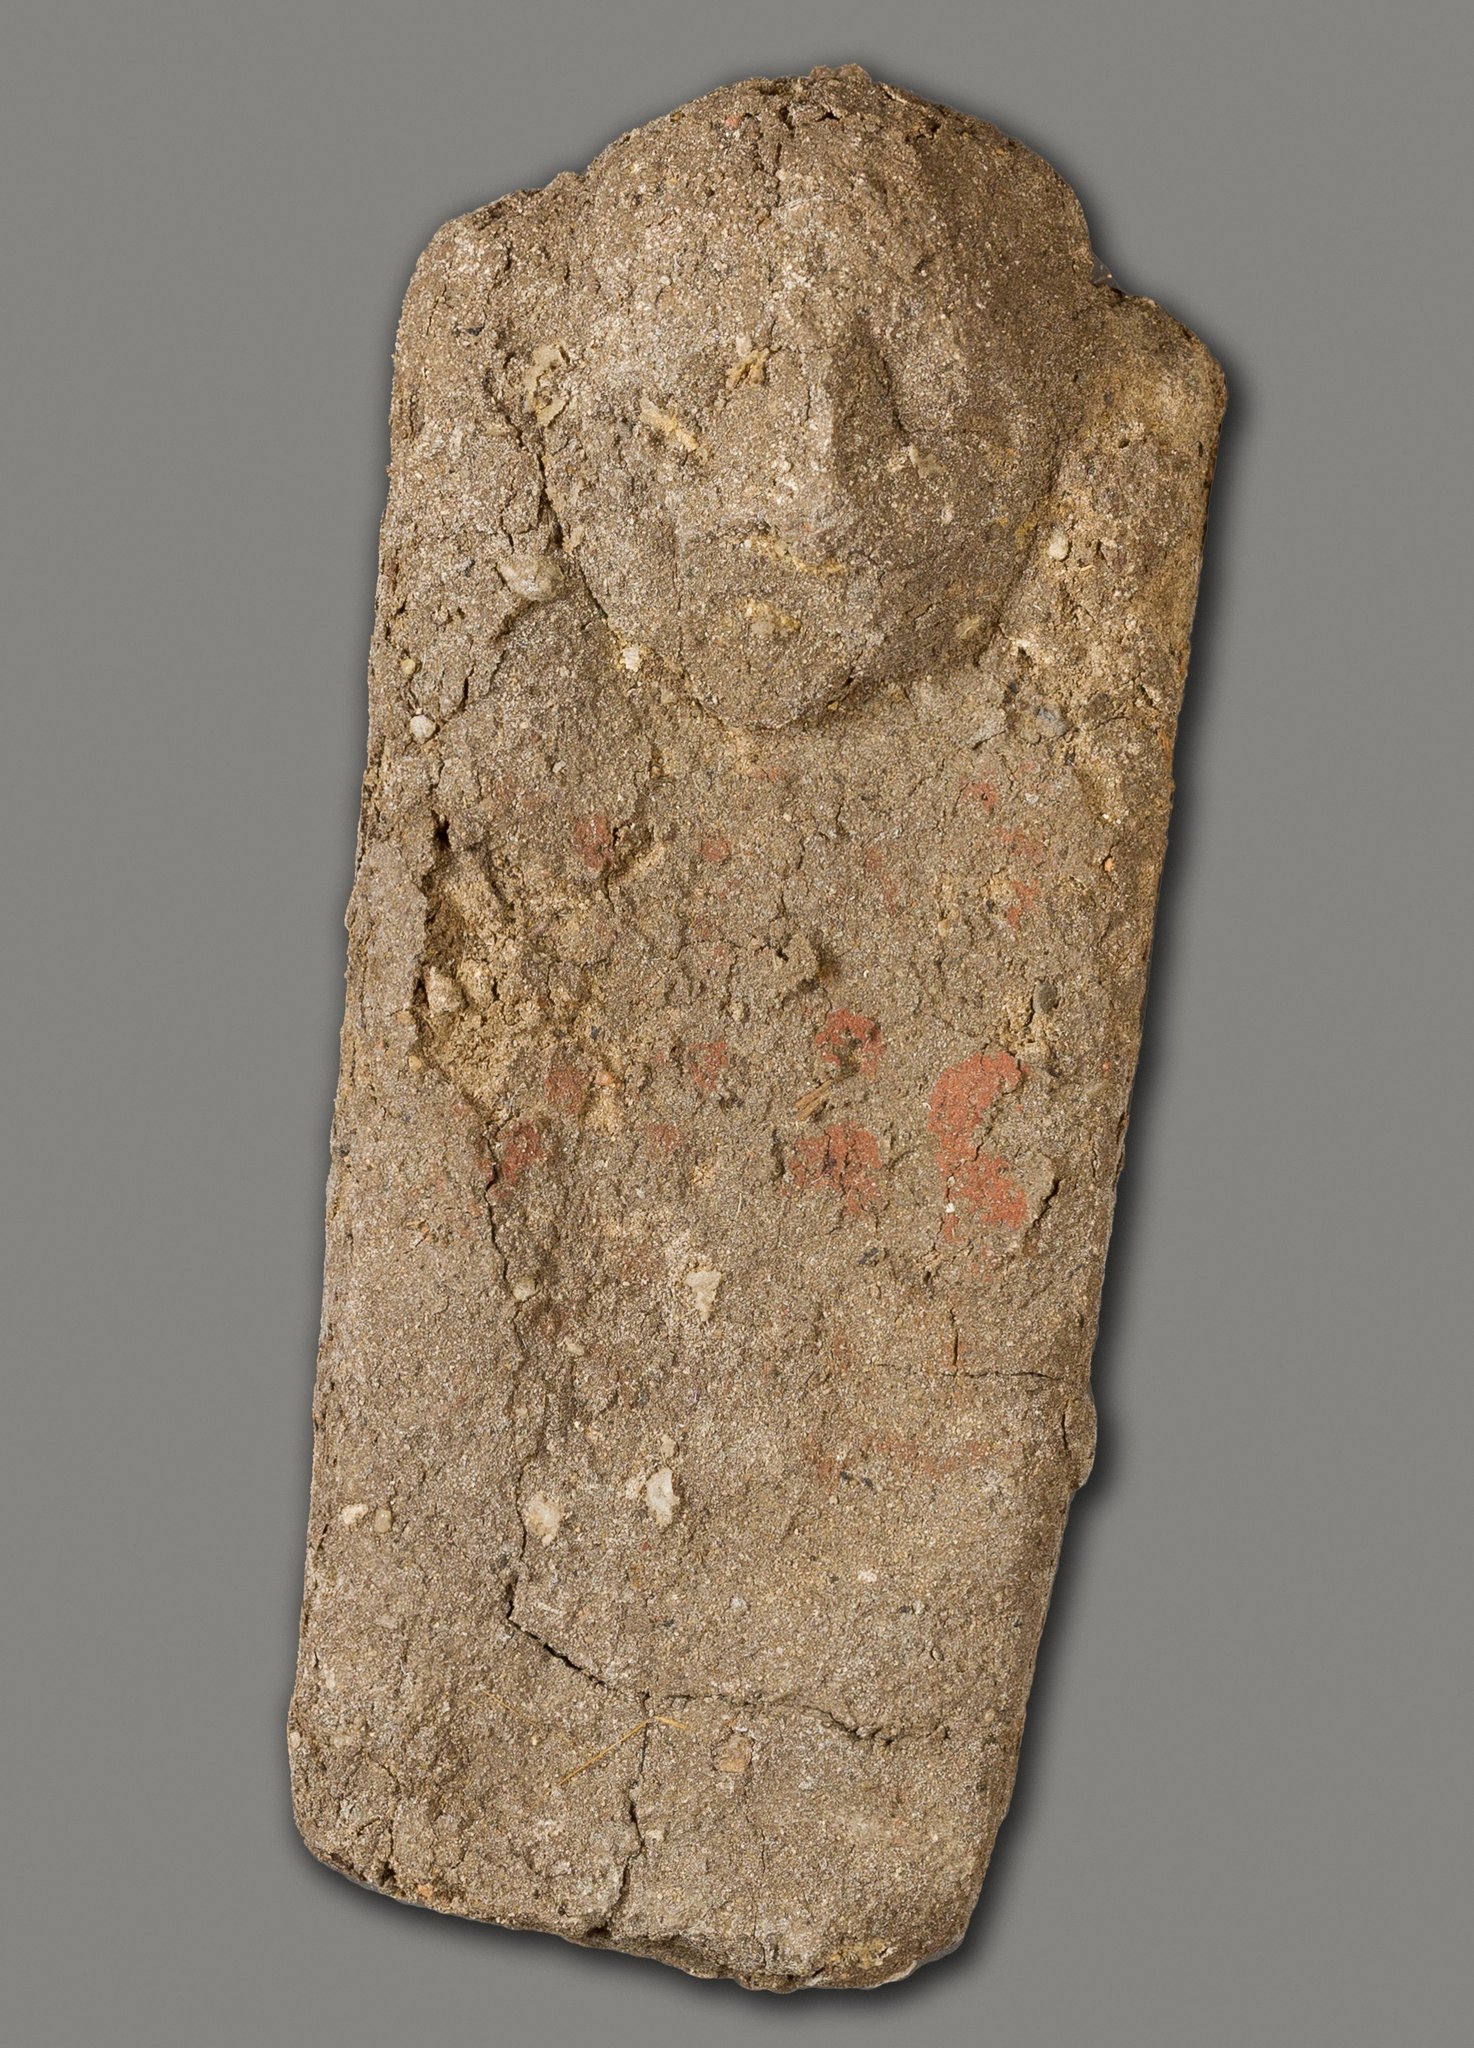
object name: figure, magical, execration, tablet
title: Magical Figure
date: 1802-1550 BCE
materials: clay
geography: egypt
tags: faces